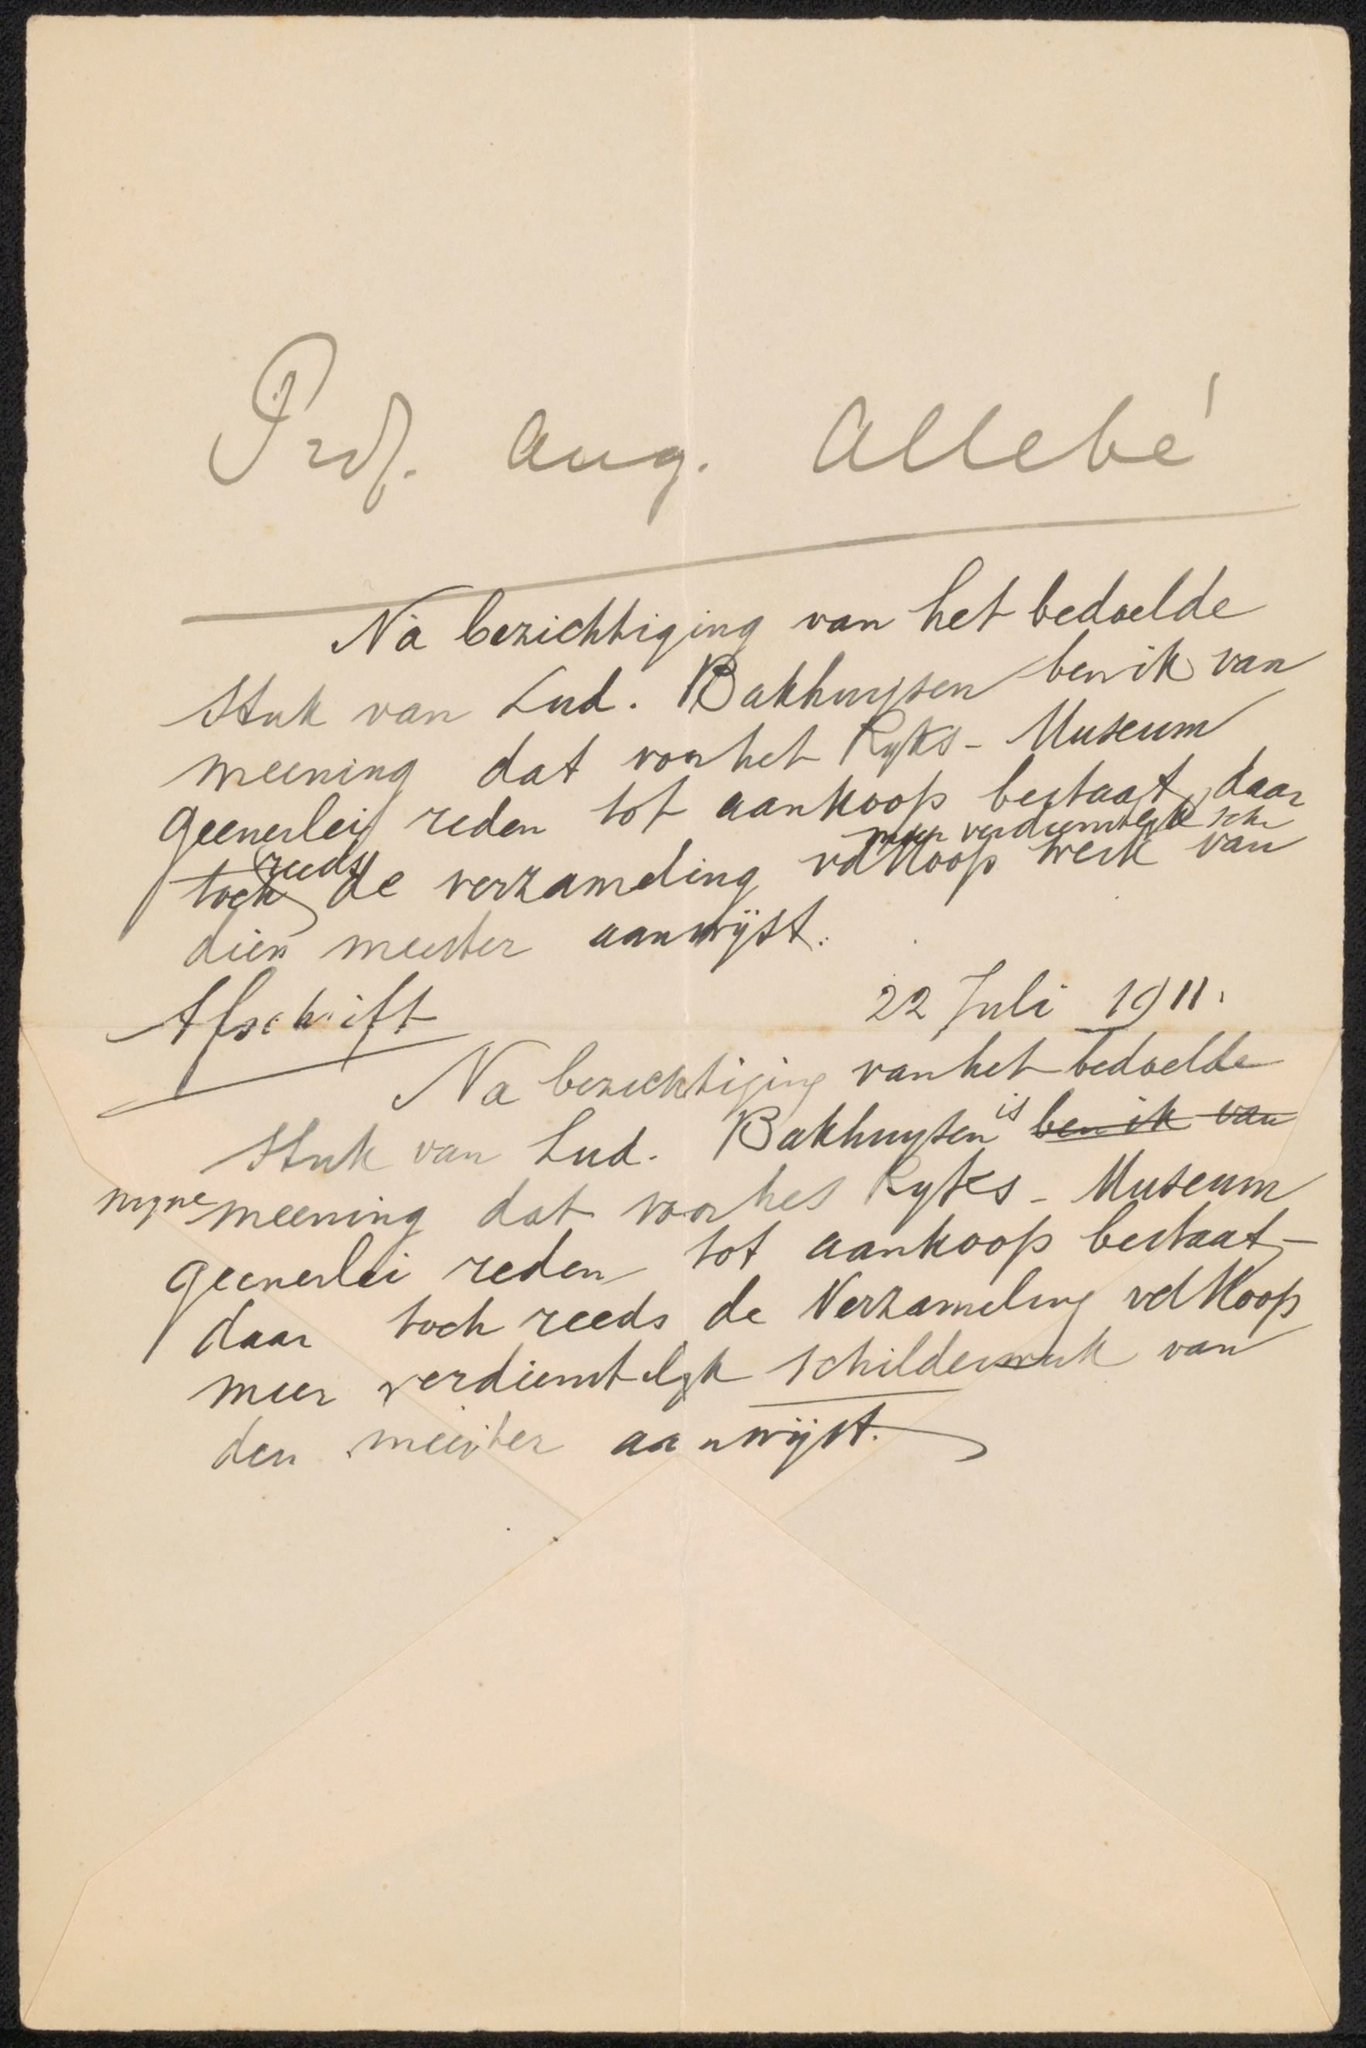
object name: letter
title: Brief aan anoniem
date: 1911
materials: ink, pencil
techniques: pen, writing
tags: ludolf bakhuysen, amsterdam, politician, adriaan van der hoop, rijksmuseum amsterdam, head (human), painting (including book-illumination, miniature-painting), art collecting